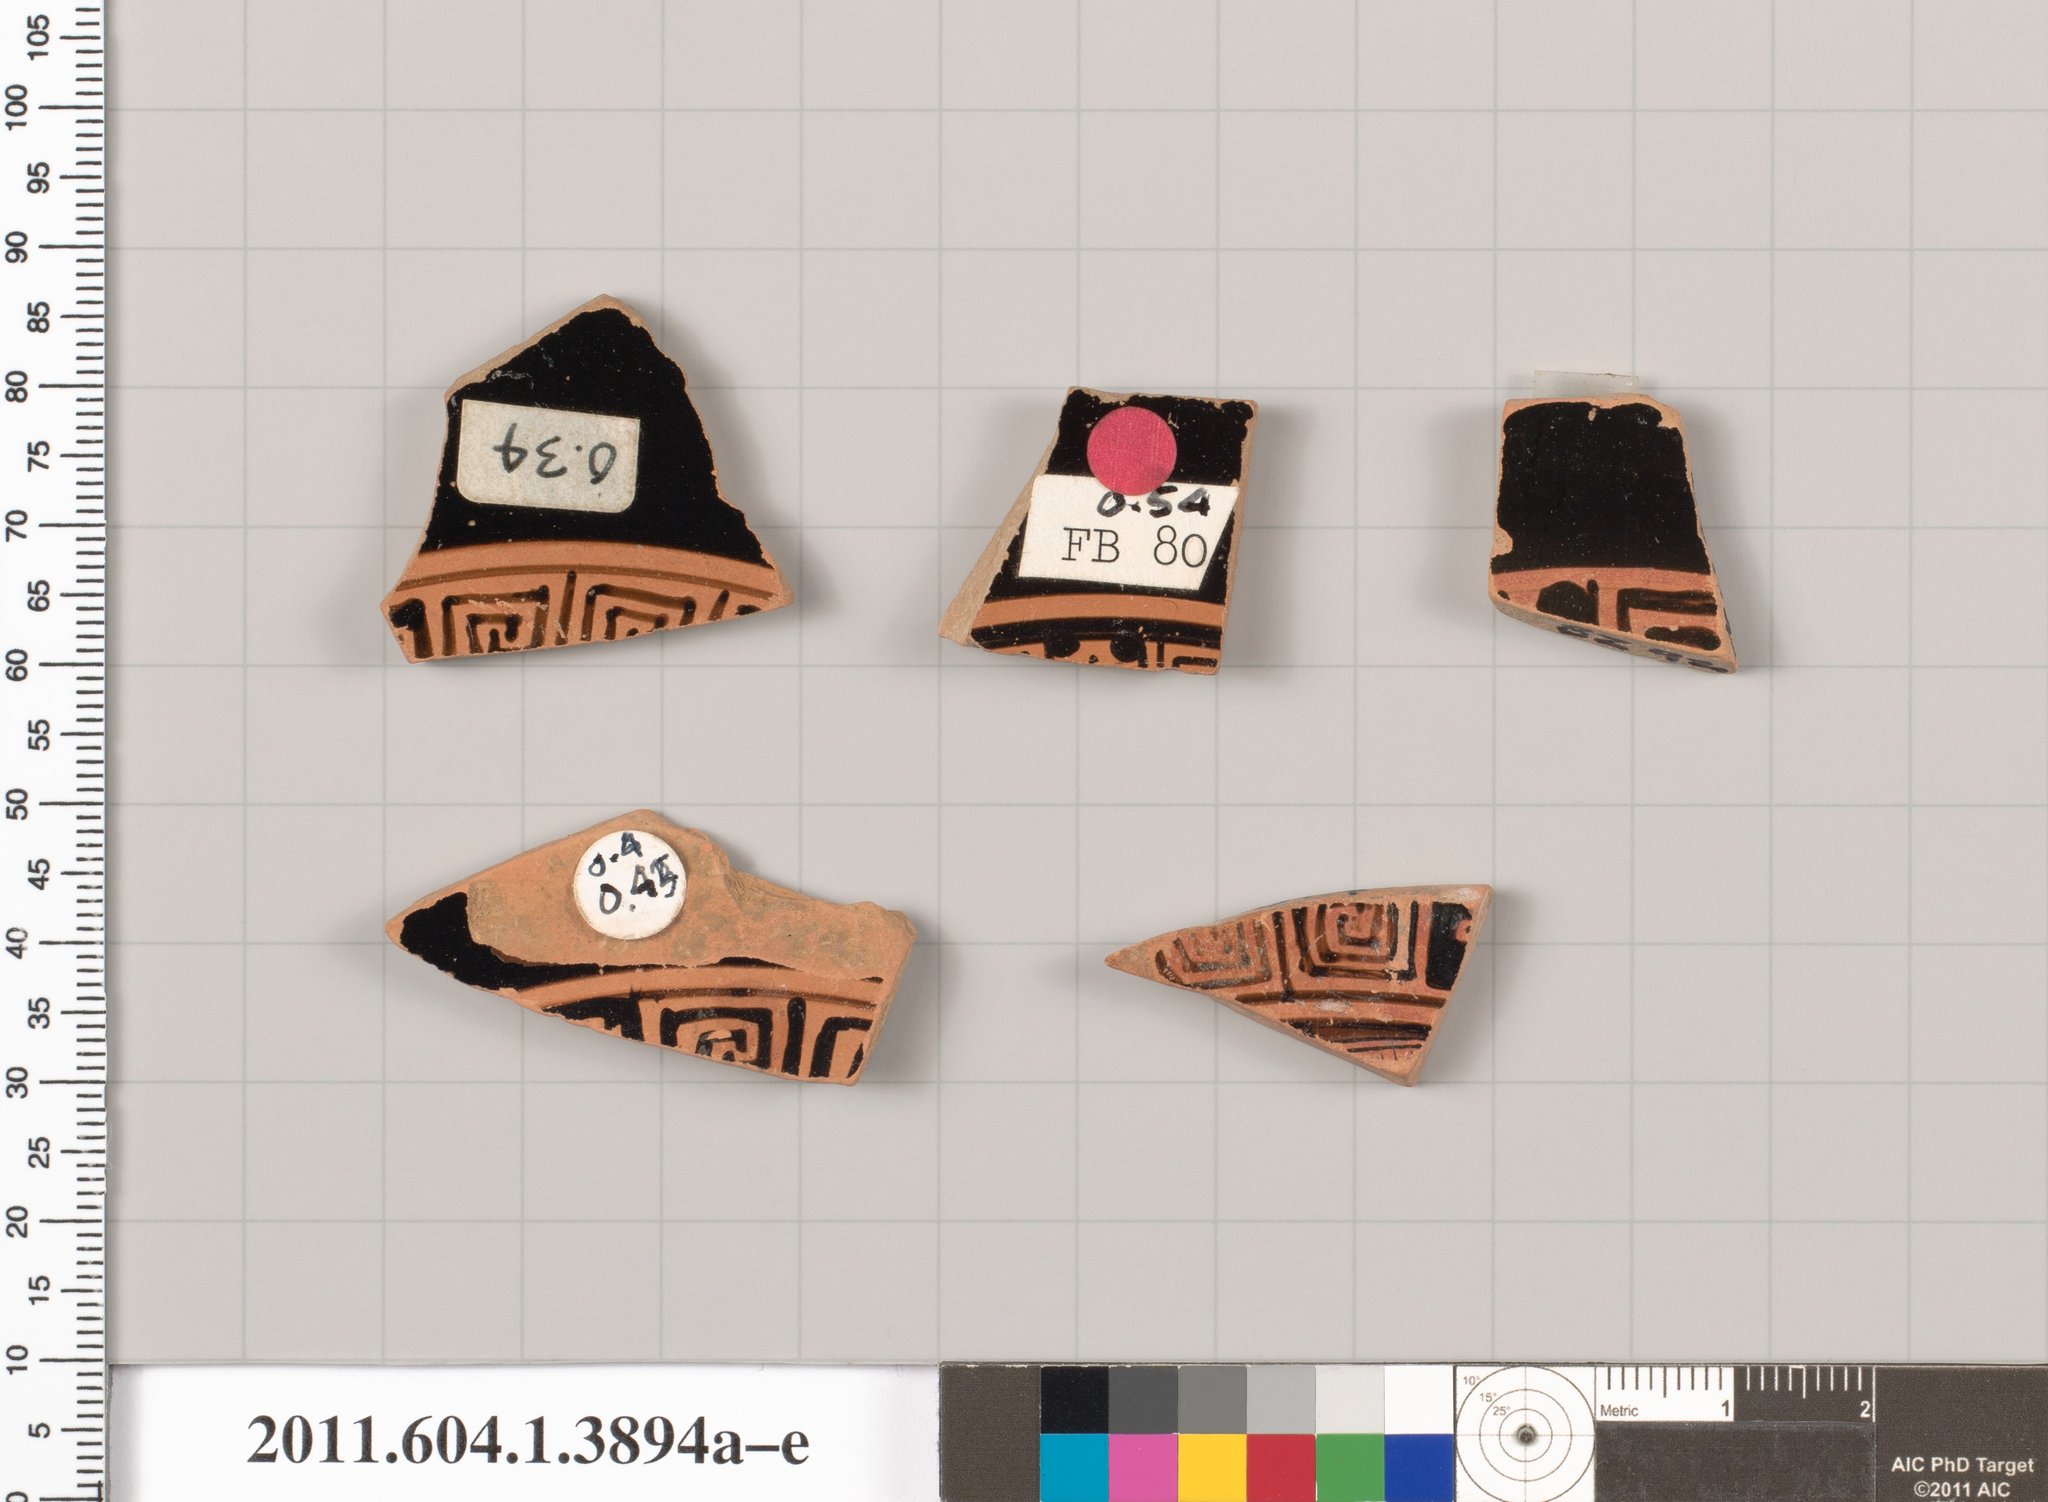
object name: kylix fragment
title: Terracotta fragments of kylikes (drinking cups)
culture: greek, attic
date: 475-451 BCE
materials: terracotta